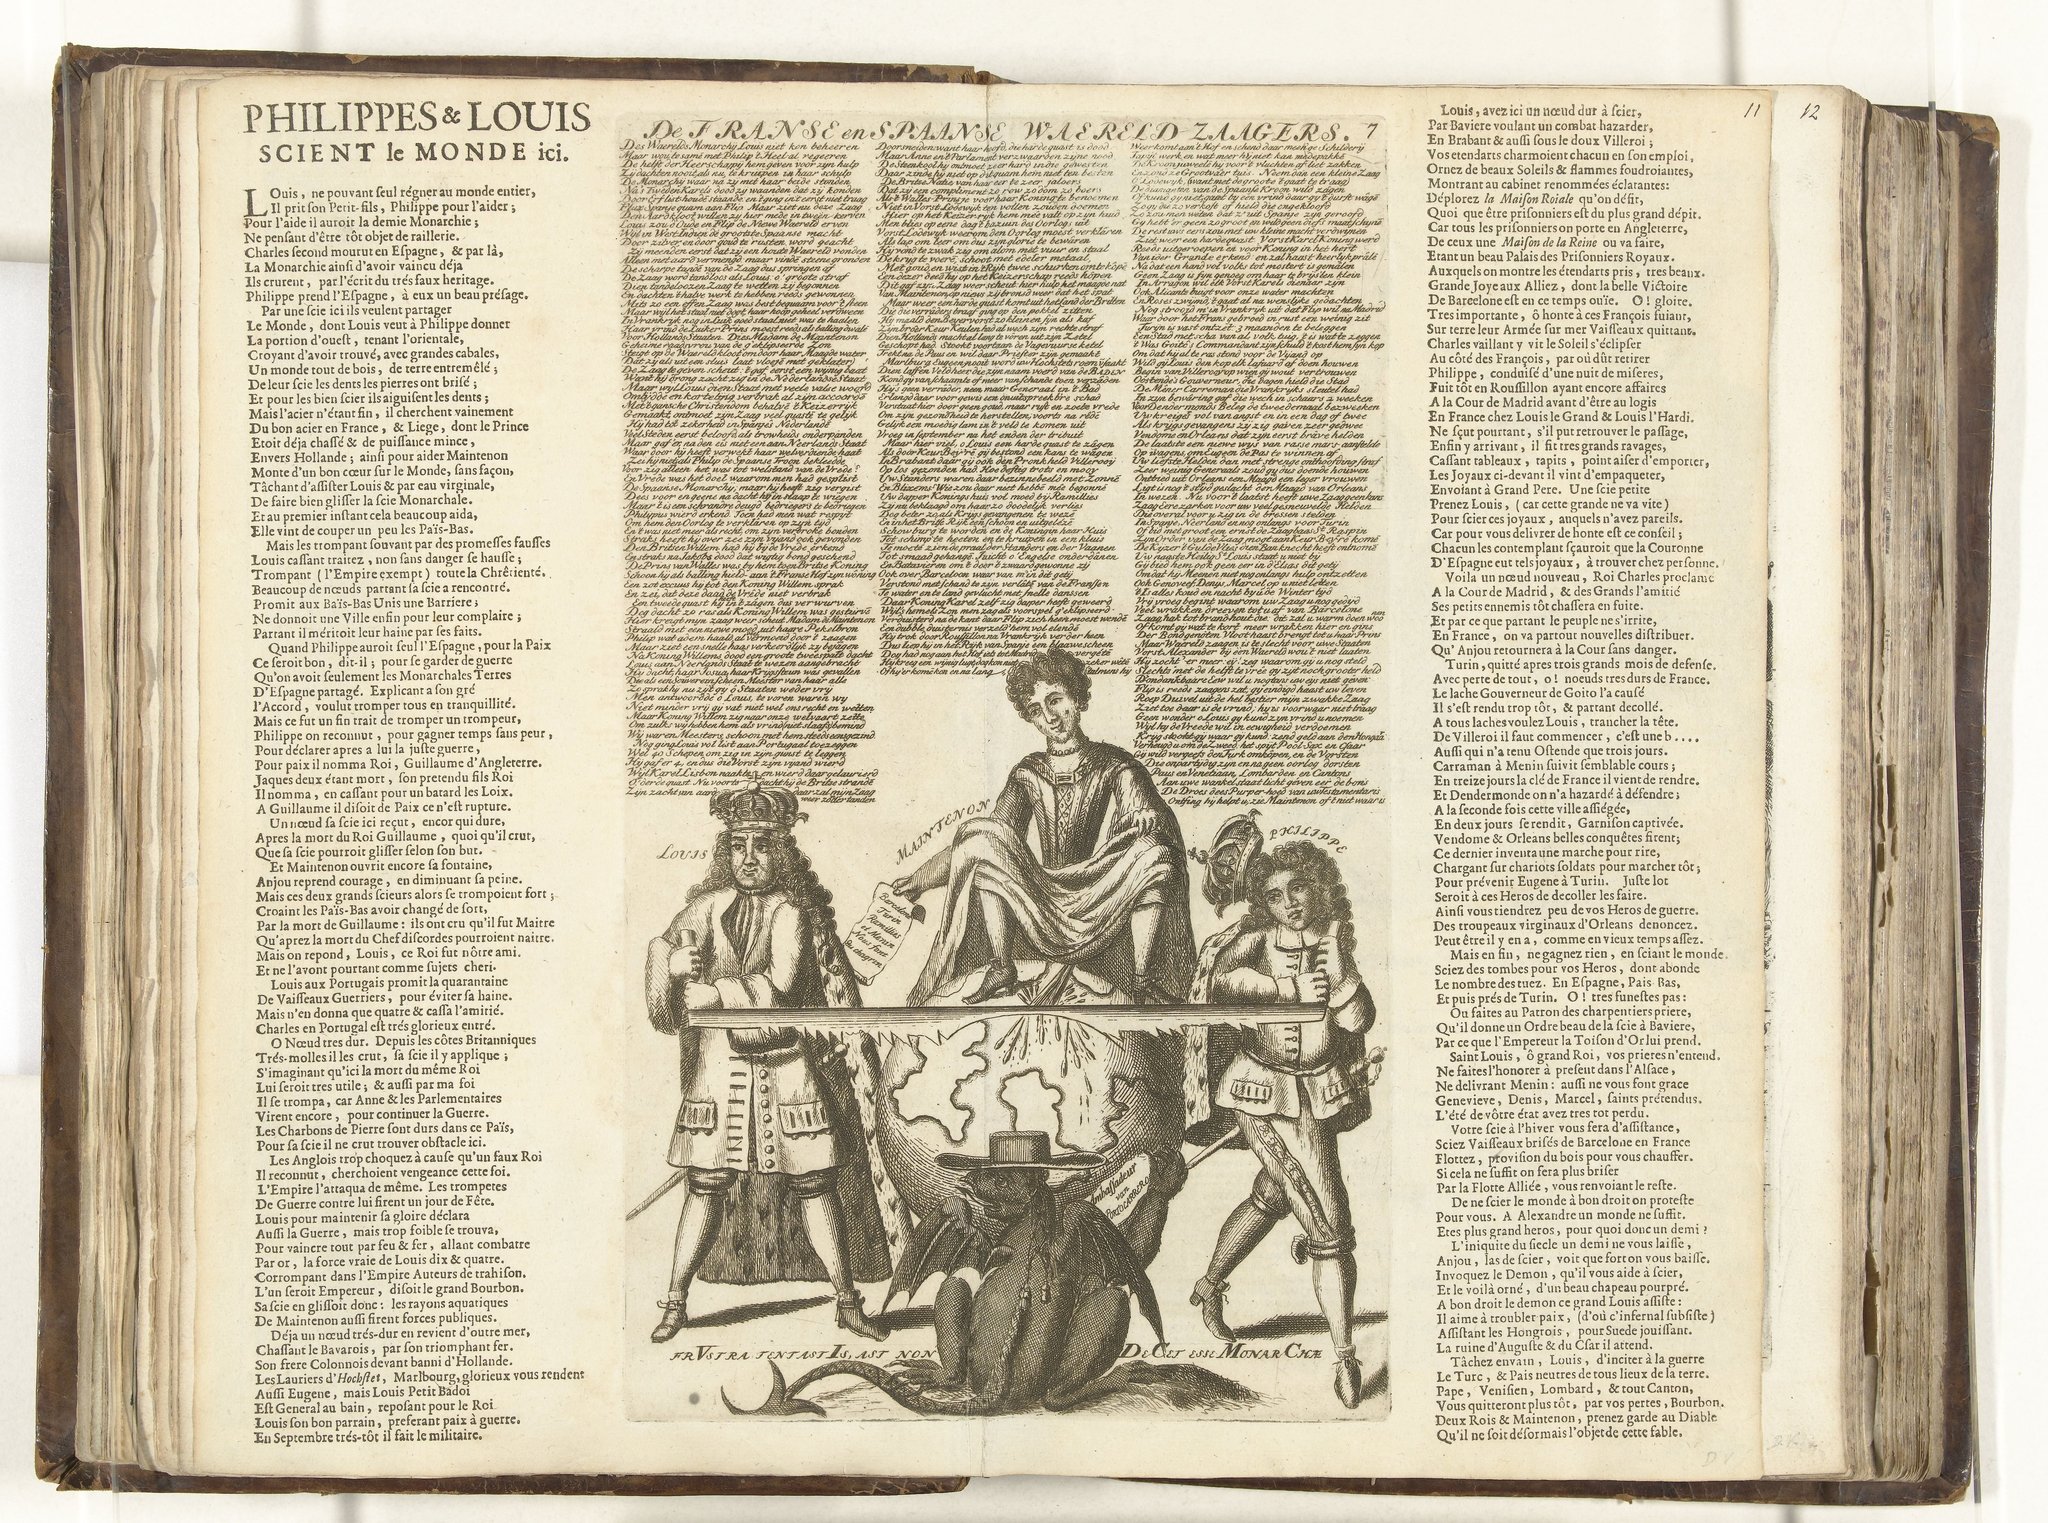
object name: cartoon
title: 7. Doofheid of de Twee Waereld-Zaagers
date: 1706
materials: paper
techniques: etching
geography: amsterdam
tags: lodewijk xiv (koning van frankrijk), madame de maintenon, filips v (koning van spanje), urination, political caricatures and satires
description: Spotprent op Lodewijk XIV en Filips V die met een grote zaag de wereld in tweeën proberen te zagen. Bovenop de wereldbol zit Madame de Maintenon die op de zaag plast om het blad te smeren. Op de voorgrond een duivel met kardinaalshoed van Portocarrero. In de plaat 3 kolommen in het Nederlands, op het blad om de plaat 2 kolommen in het Frans. Blad nr. 7 (genummerd rechtsboven) in de serie van 25 bladen getiteld: Byvoegsel tot de Koninglyke Almanach, genaamd het Gulde-Jaar der Bondgenooten, 1706. Onderdeel van het prentwerk uitgegeven onder de verzameltitel: 't Lust-Hof van Momus, met de gebundelde series van spotprenten tijdens de jaren 1701-1713 van de Spaanse Successieoorlog.